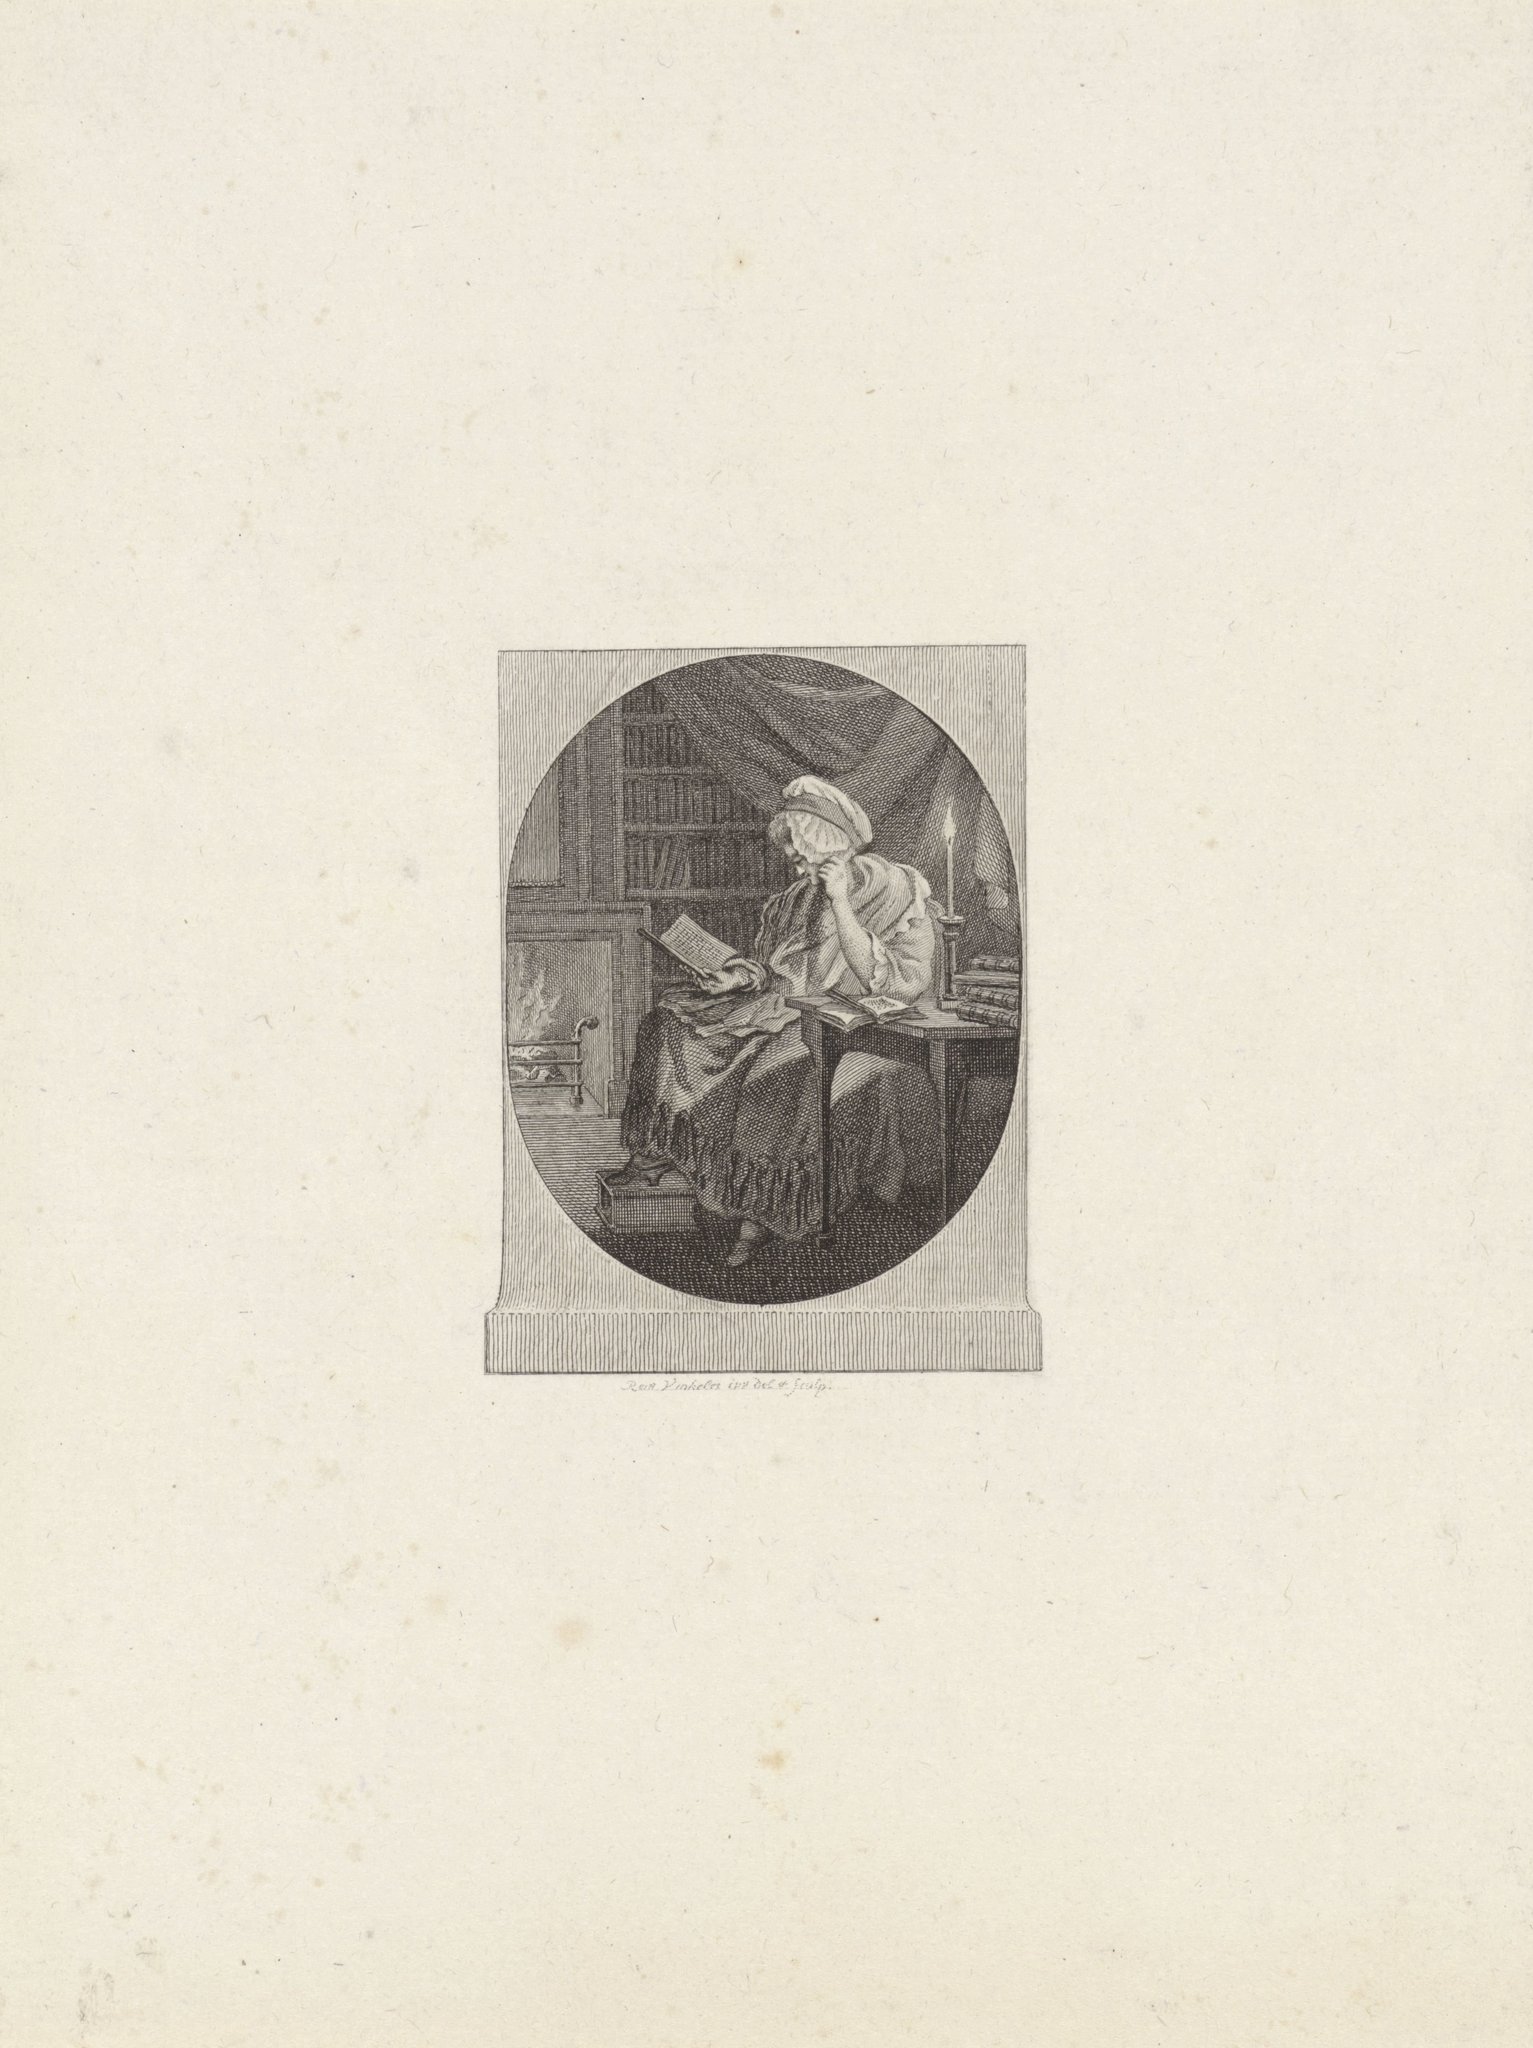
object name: print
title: Titelpagina voor: E. M. Post, 'Voor Eenzaamen', 1789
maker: reinier vinkeles (i)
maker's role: draughtsman, print maker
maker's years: 1741-1816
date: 1789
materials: paper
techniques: engraving, etching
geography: amsterdam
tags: reading, candle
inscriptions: collector's mark: Lugt 240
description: Proefdruk van titelpagina voor: Post, Elisabeth Maria. Voor eenzaamen. Amsterdam: Johannes Allart, 1789.